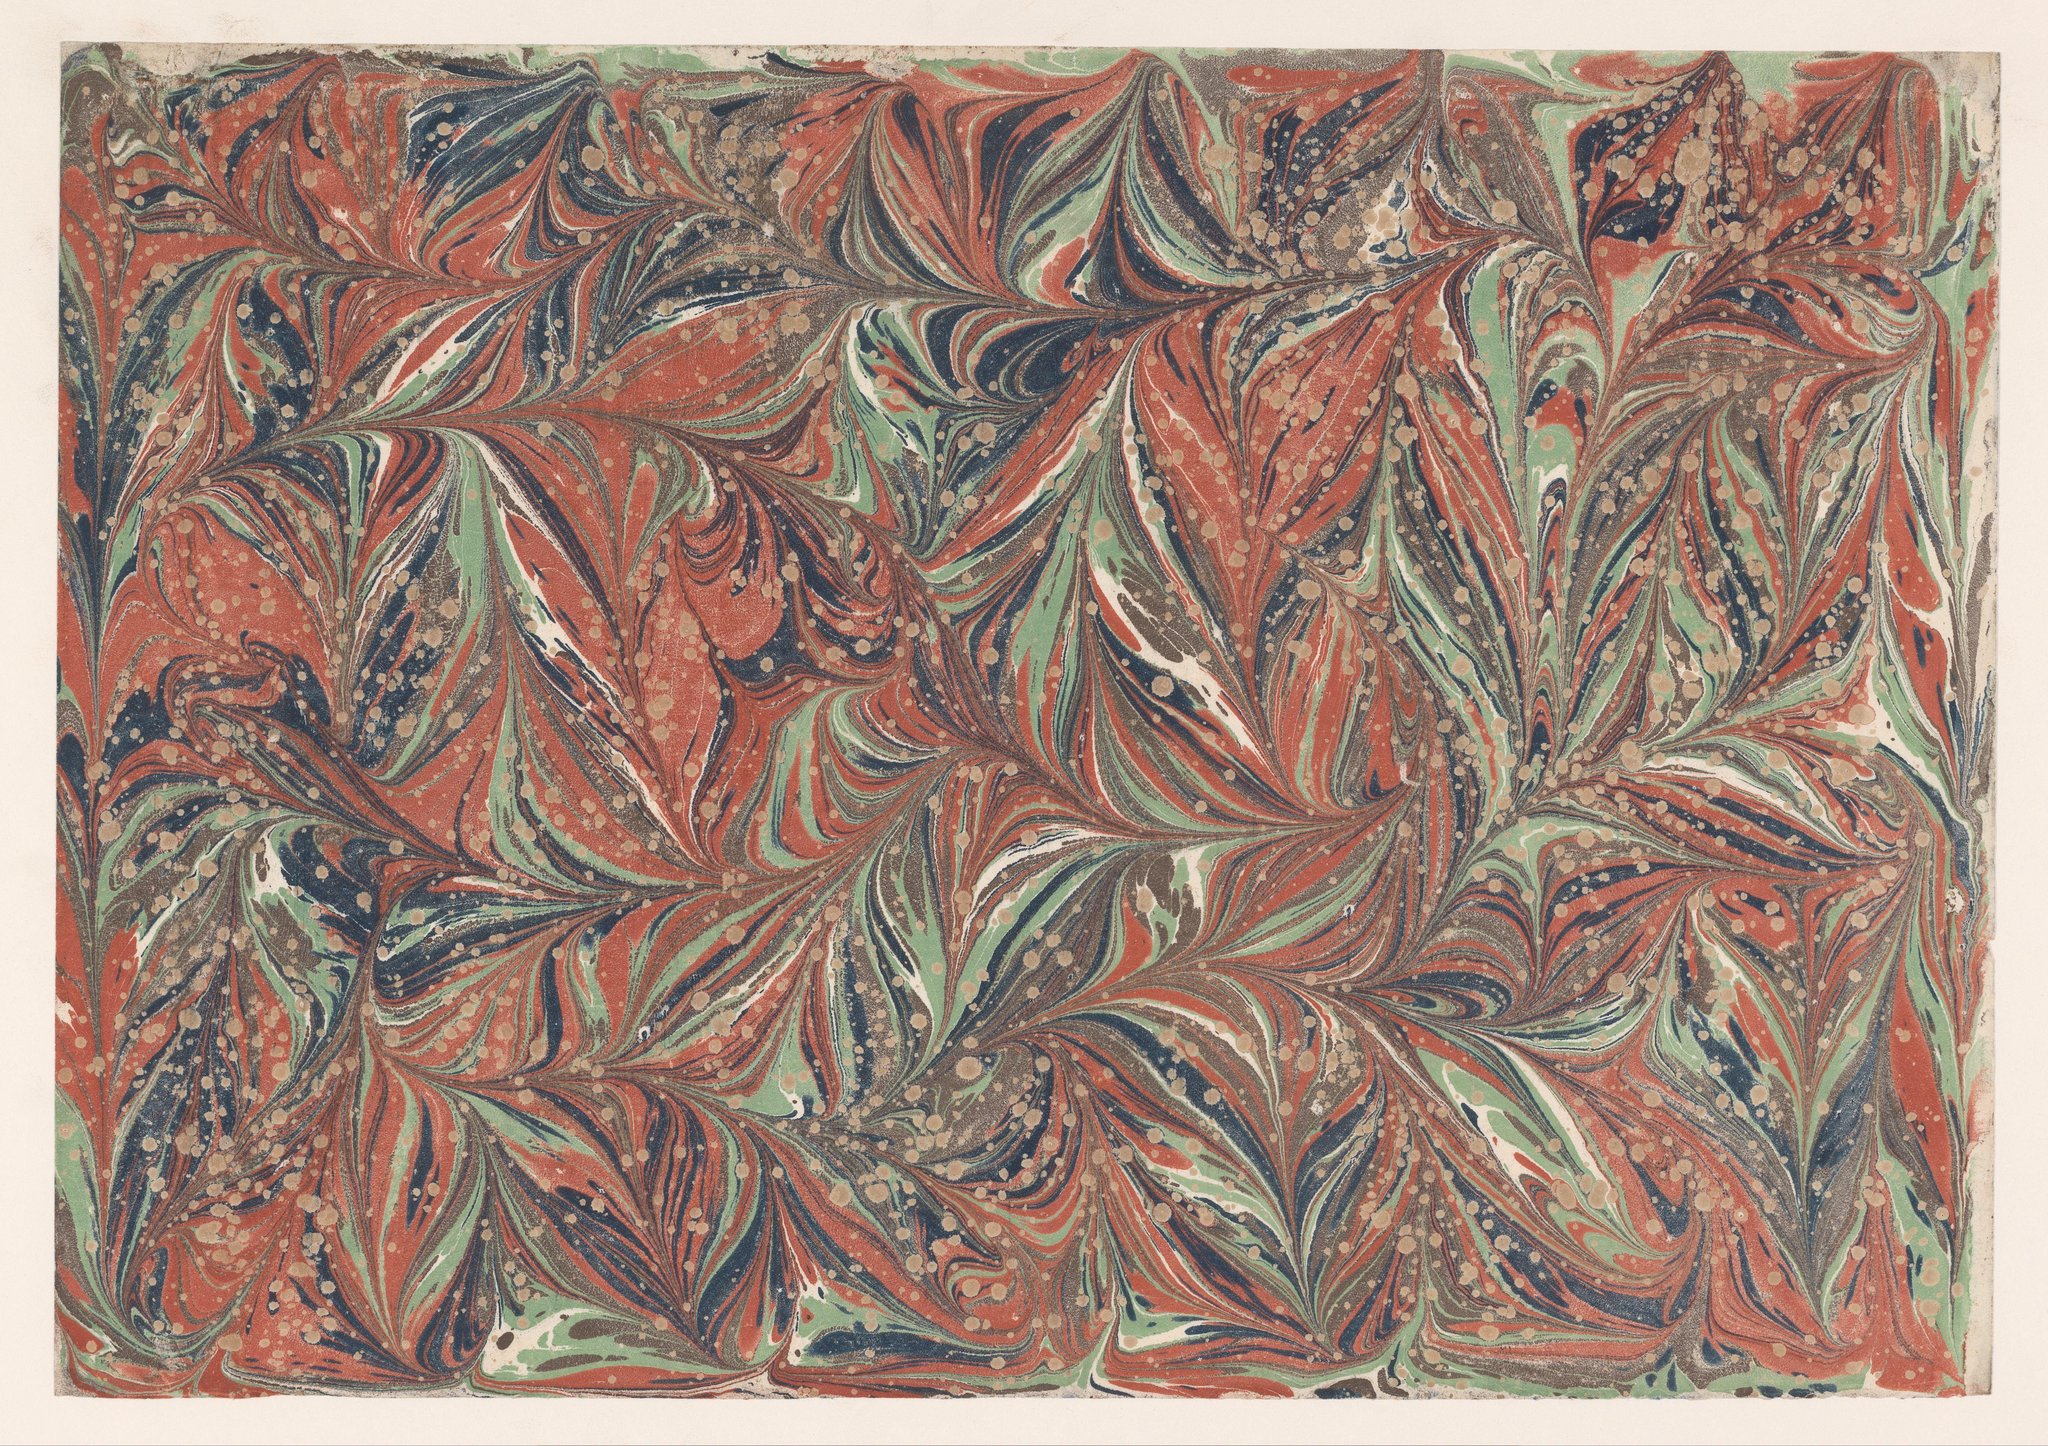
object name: marbled paper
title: Dubbelmarmering van kiezelmarmer op een golfslagmarmer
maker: Anonymous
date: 1950-2000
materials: paint, paper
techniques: wave marble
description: Dubbelmarmering van kiezelmarmer in bruin op een golfslagmarmer in rood, groen, bruin en blauw.